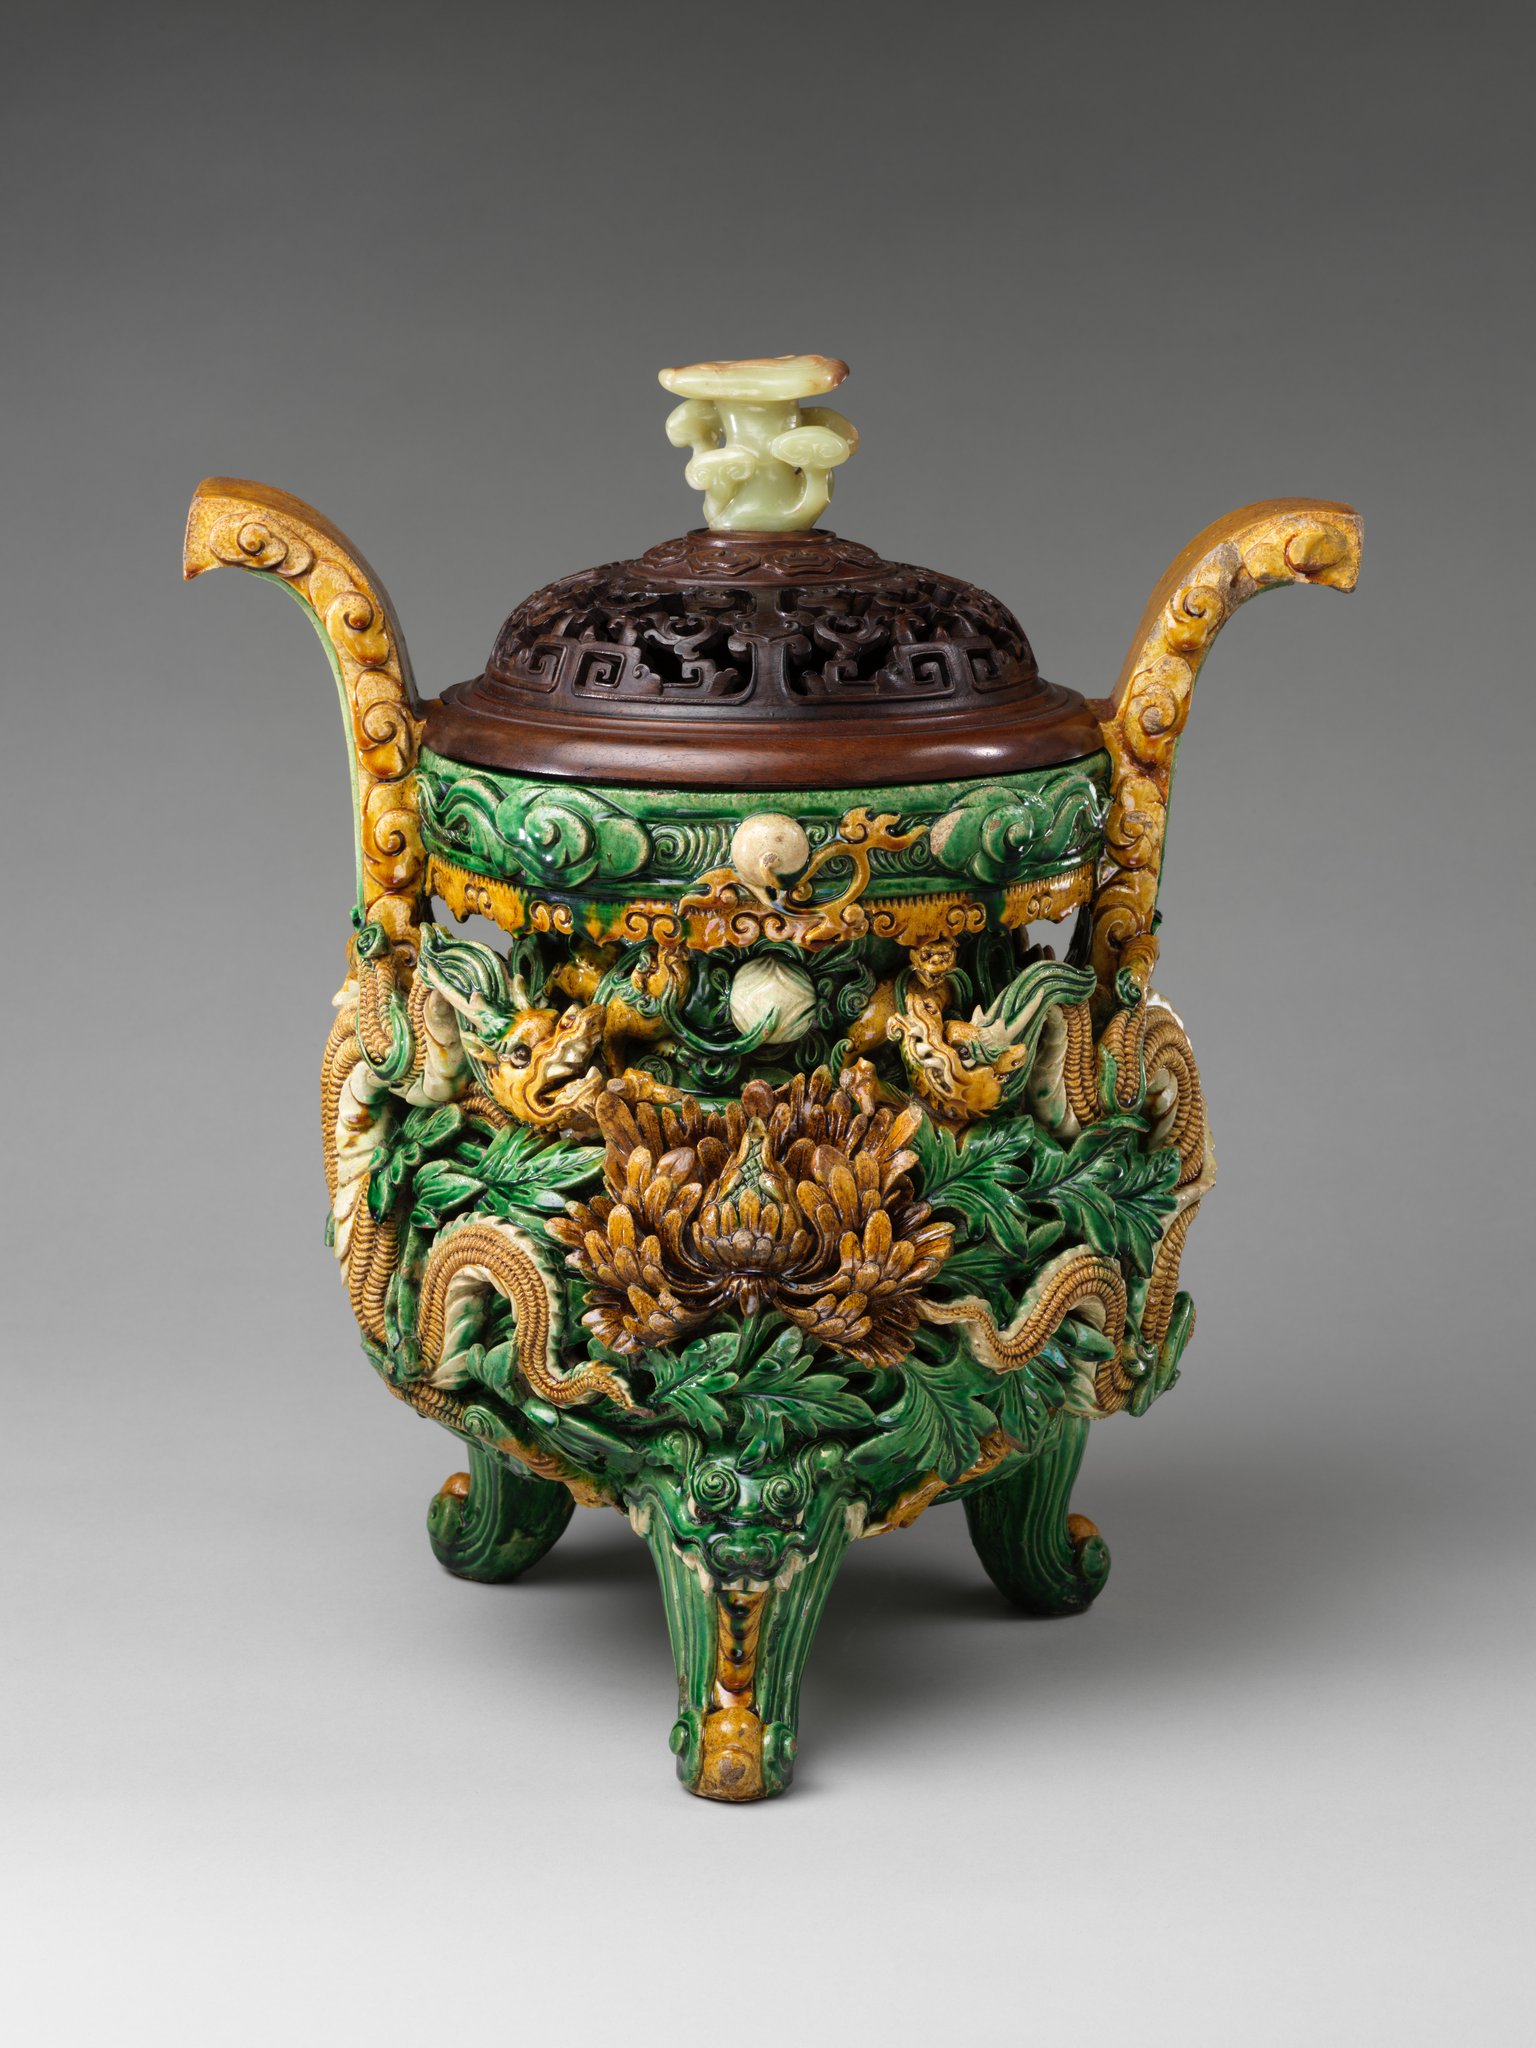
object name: incense burner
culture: chinese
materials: glaze, stoneware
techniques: relief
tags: dragons